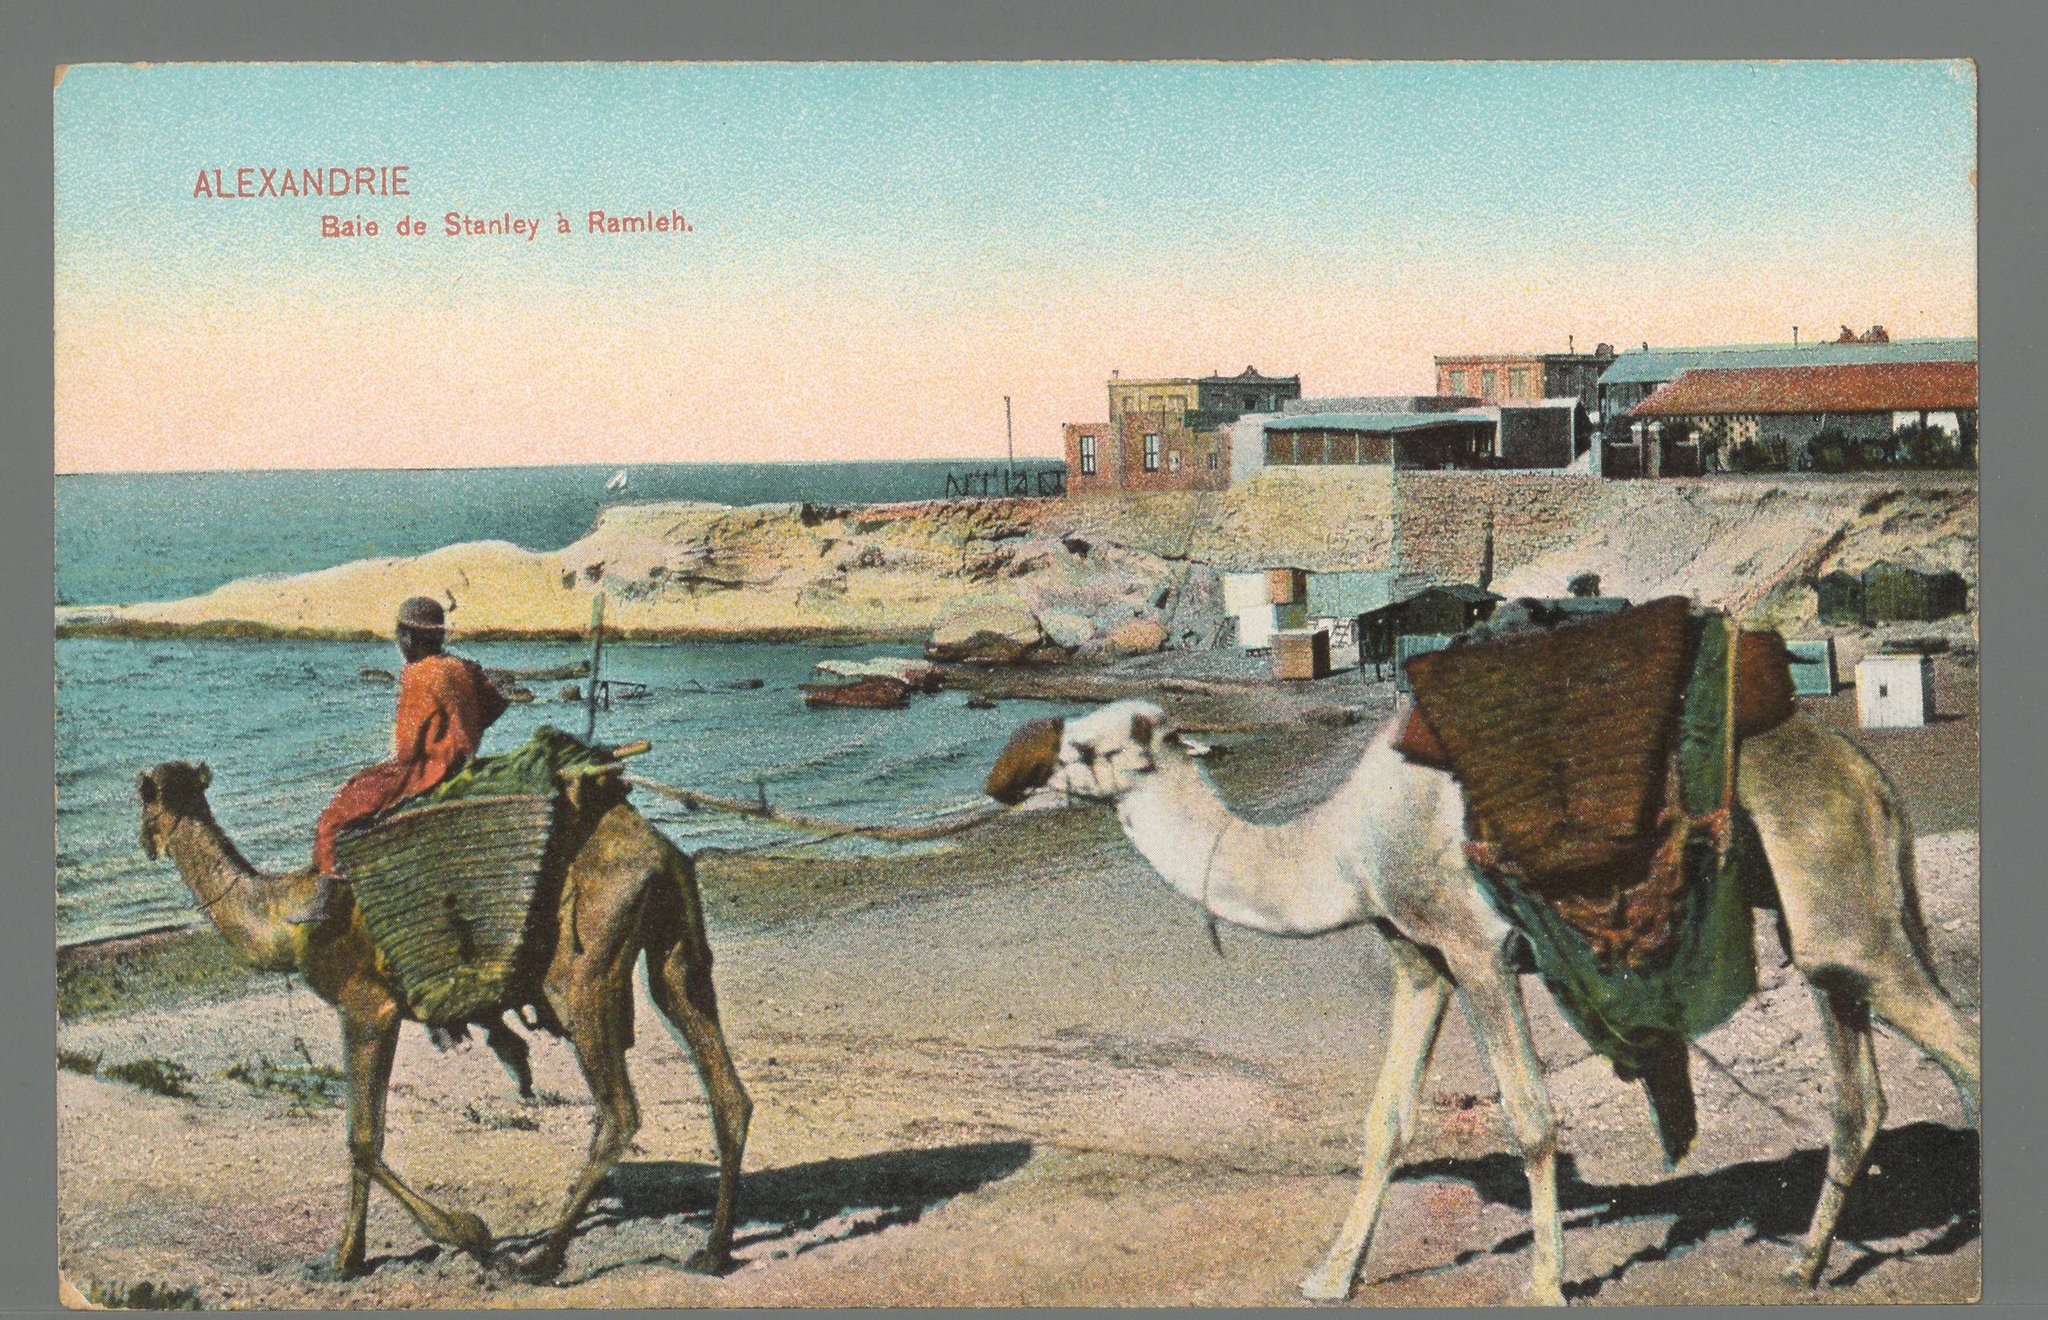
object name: ansichtkaart, prentbriefkaart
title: Alexandrie. Baie de Stanley à Ramleh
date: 1905-1930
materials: cardboard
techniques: lithograph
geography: alexandria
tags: gulf, bay, hoofed animals: camel